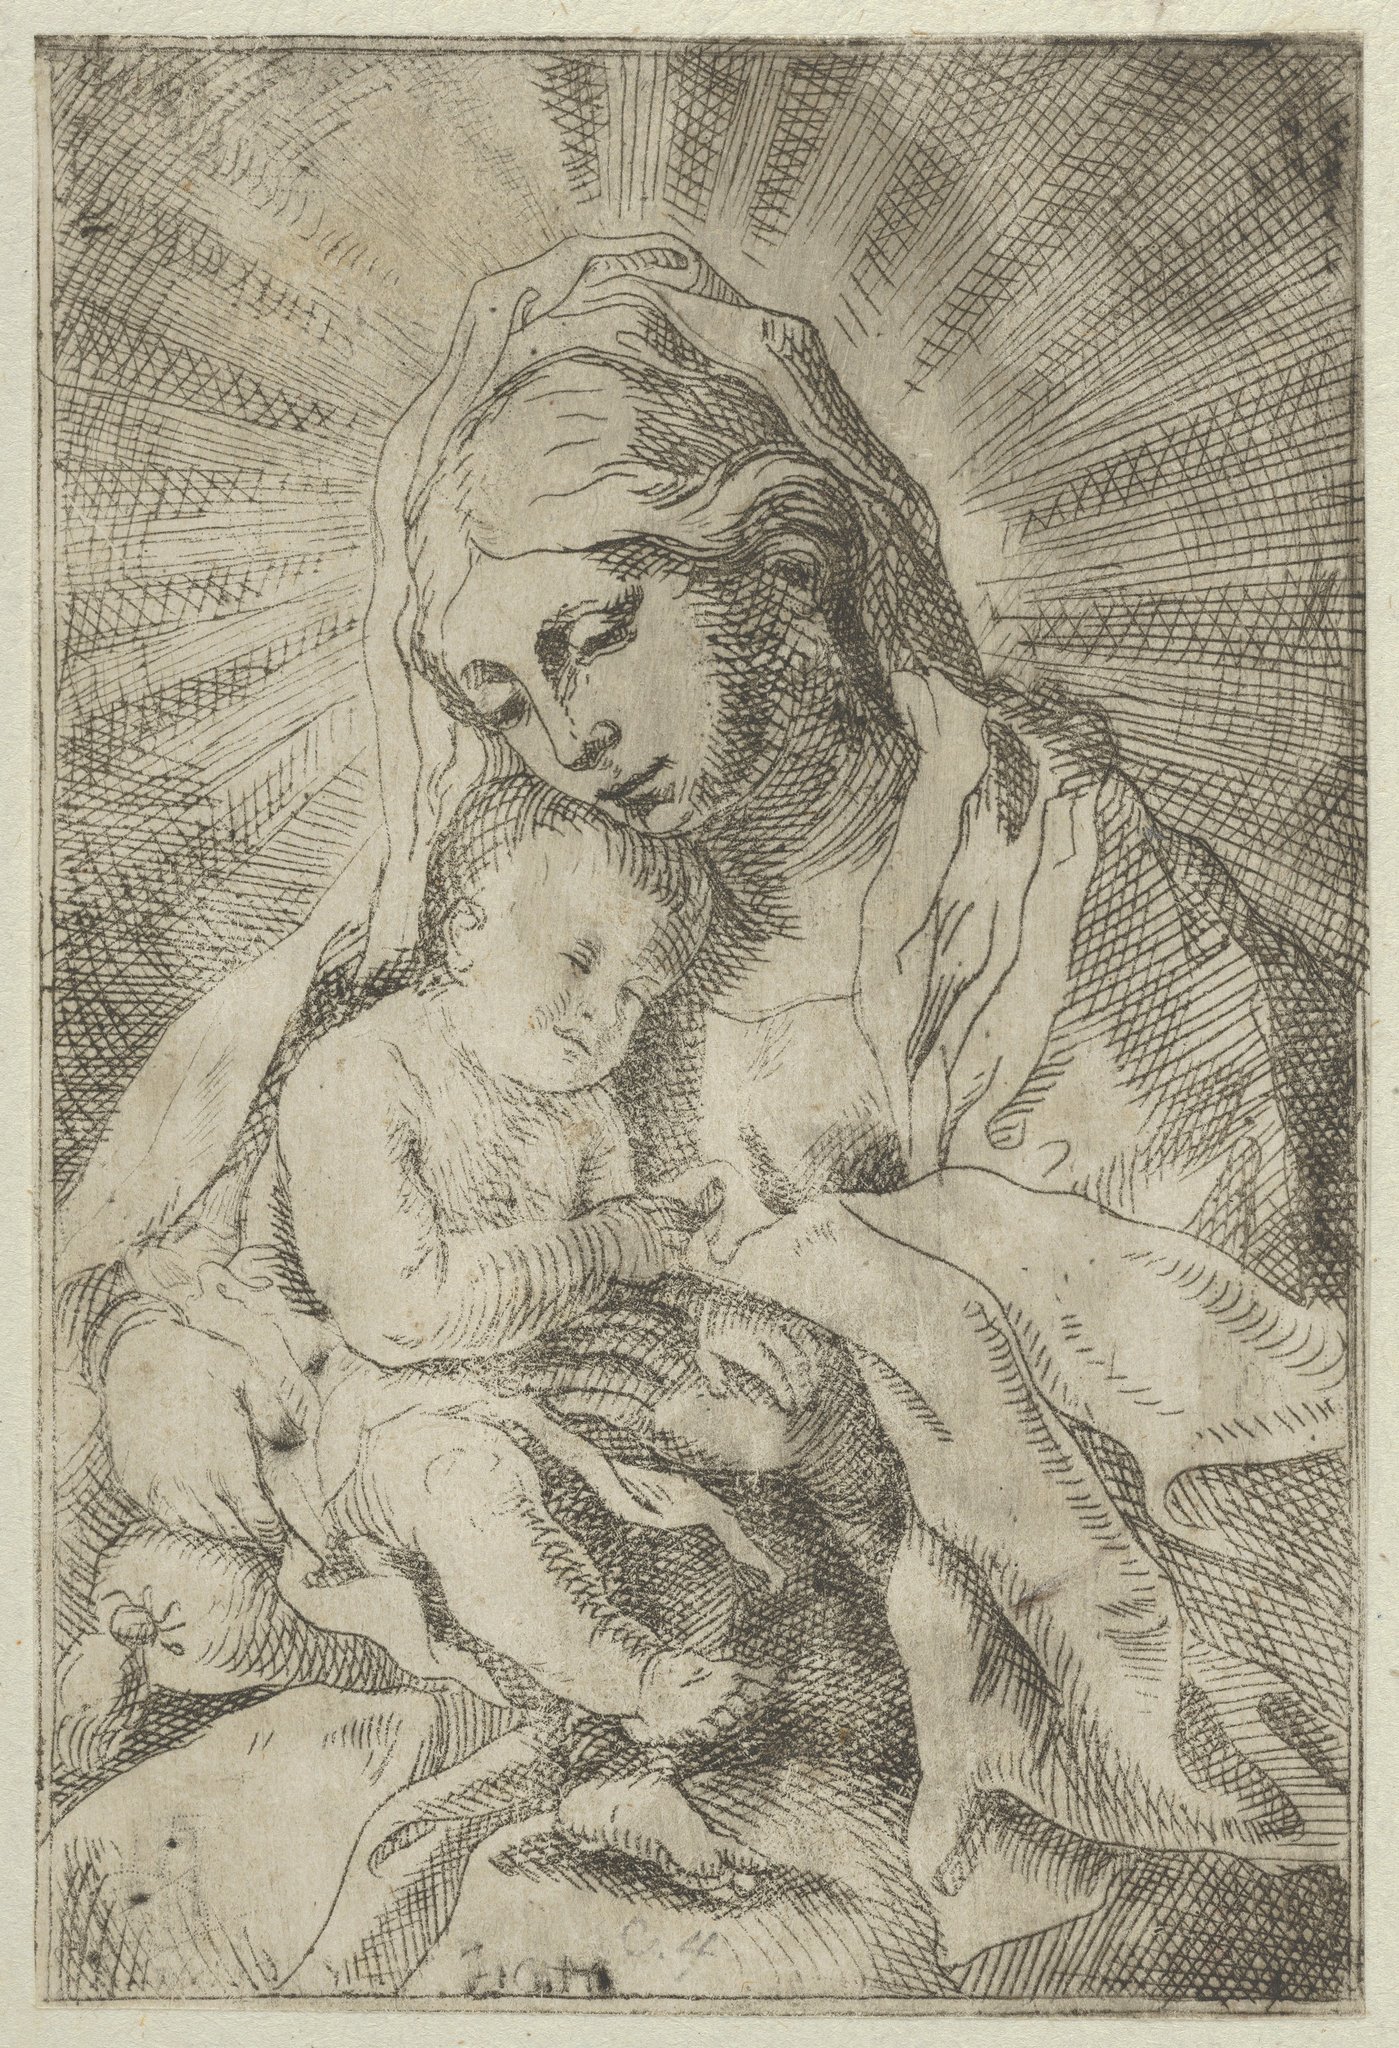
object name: print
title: The Virgin holding the infant Christ, after Reni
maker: anonymous, 17th century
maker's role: artist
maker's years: 1600-1700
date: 1600-1640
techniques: etching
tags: madonna and child